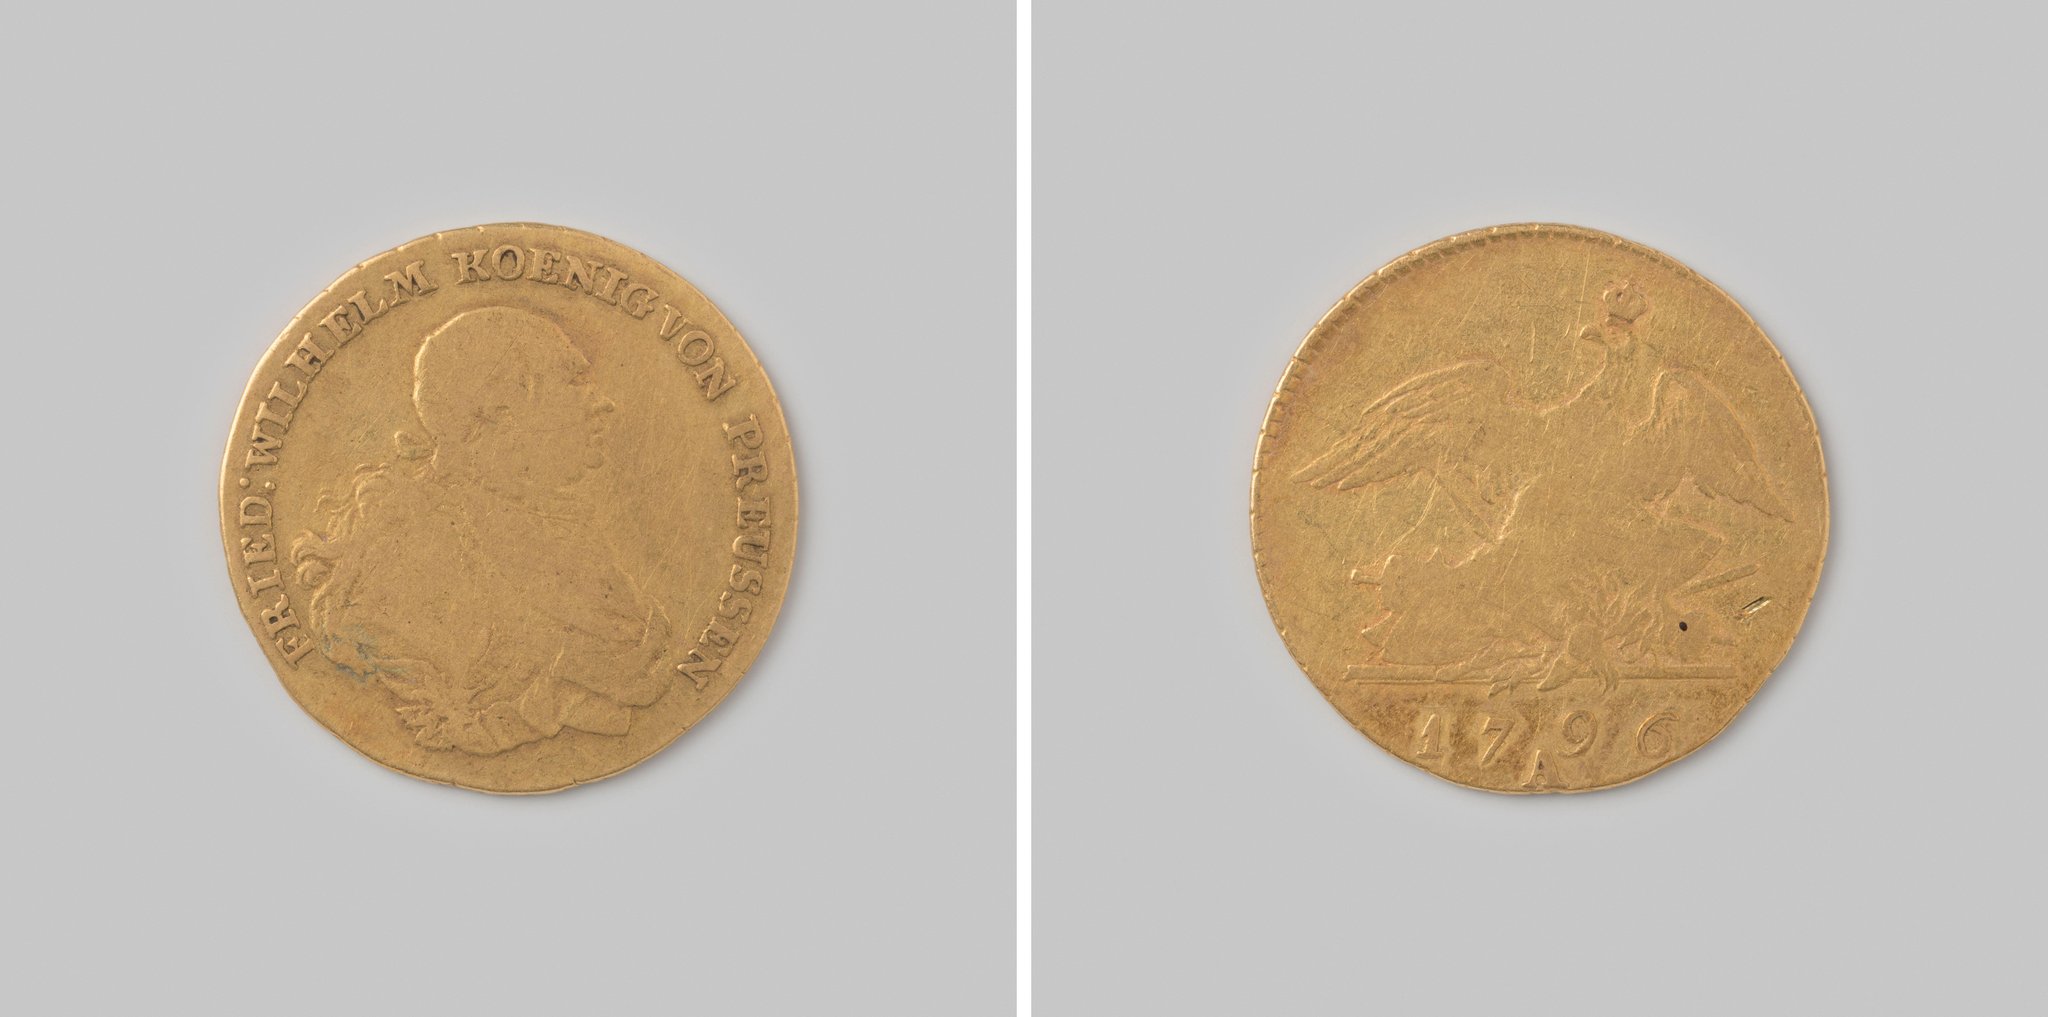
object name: coin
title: Pruisen, Friedrich Wilhelm II, friedrich d'or, 1796 A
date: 1796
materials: gold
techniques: striking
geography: berlin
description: Gouden munt. Voorzijde: borstbeeld van de koning naar rechts. Keerzijde: uit oorlogstrofeeën oprijzende gekroonde adelaar. In afsnede jaartal, waaronder letter A. Kartelrand.